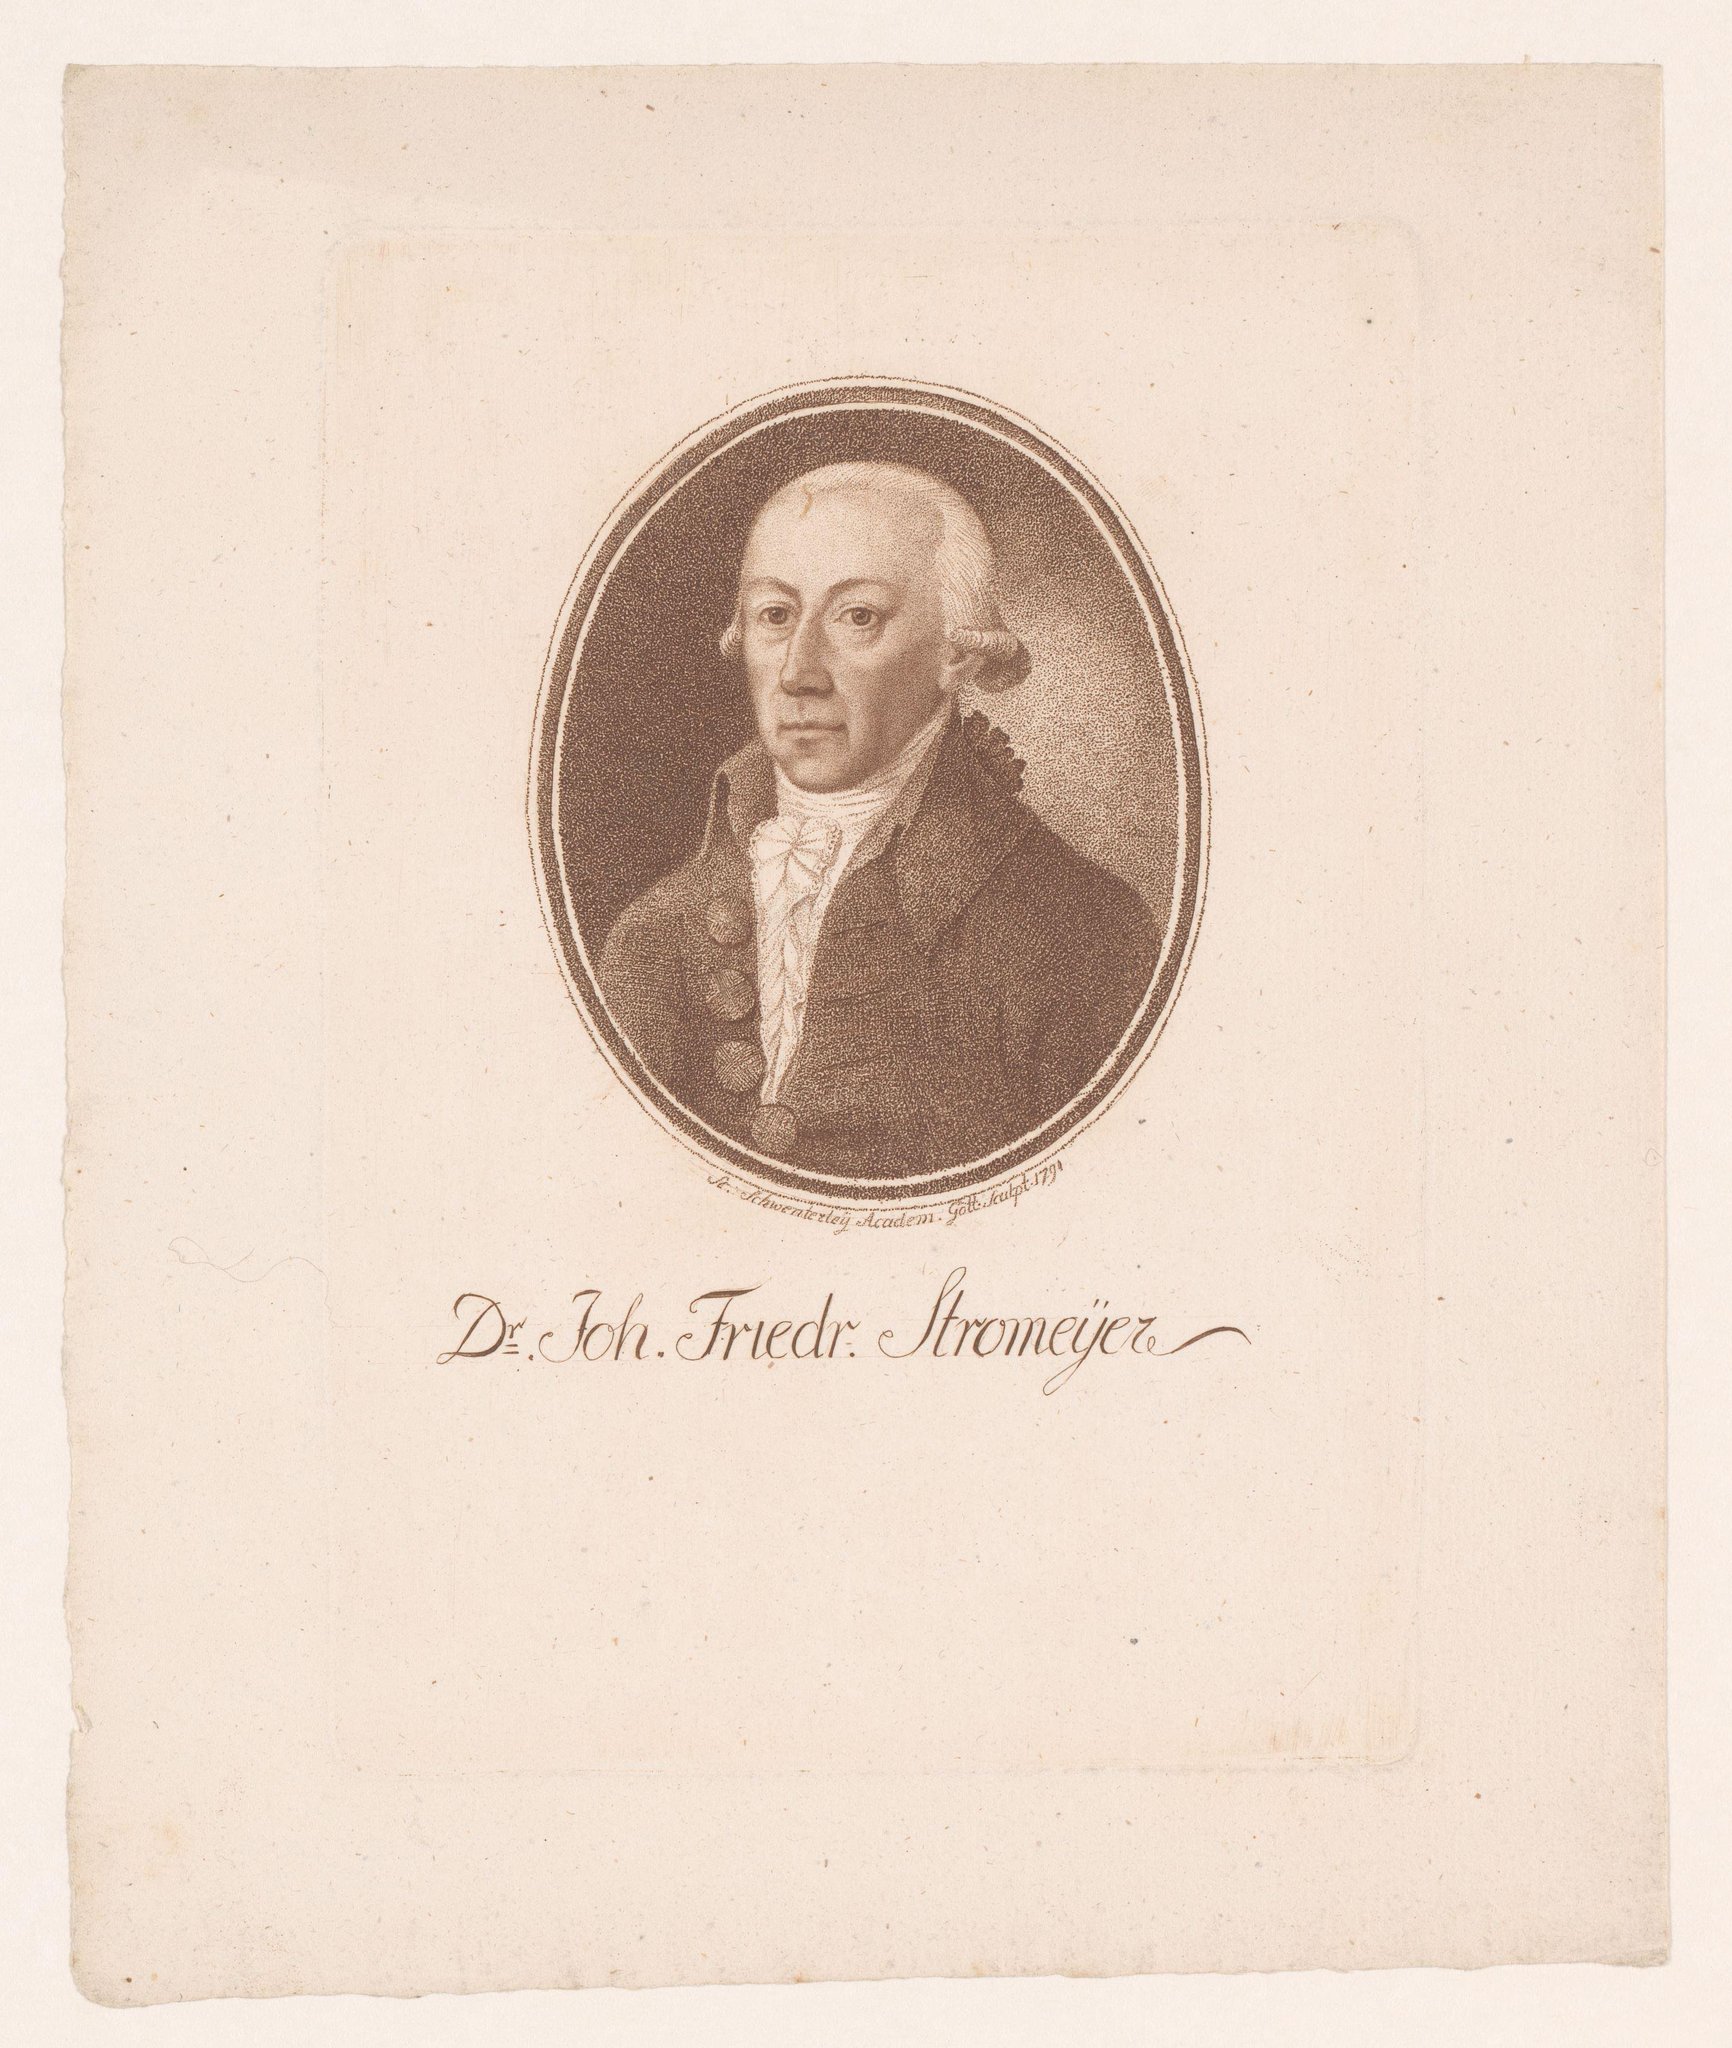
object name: print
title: Portret van Johann Friedrich Stromeyer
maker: heinrich schwenterley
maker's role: print maker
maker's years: 1749-1815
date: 1791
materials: paper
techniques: stippling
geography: gottingen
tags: historical persons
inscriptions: collector's mark: Lugt 2228